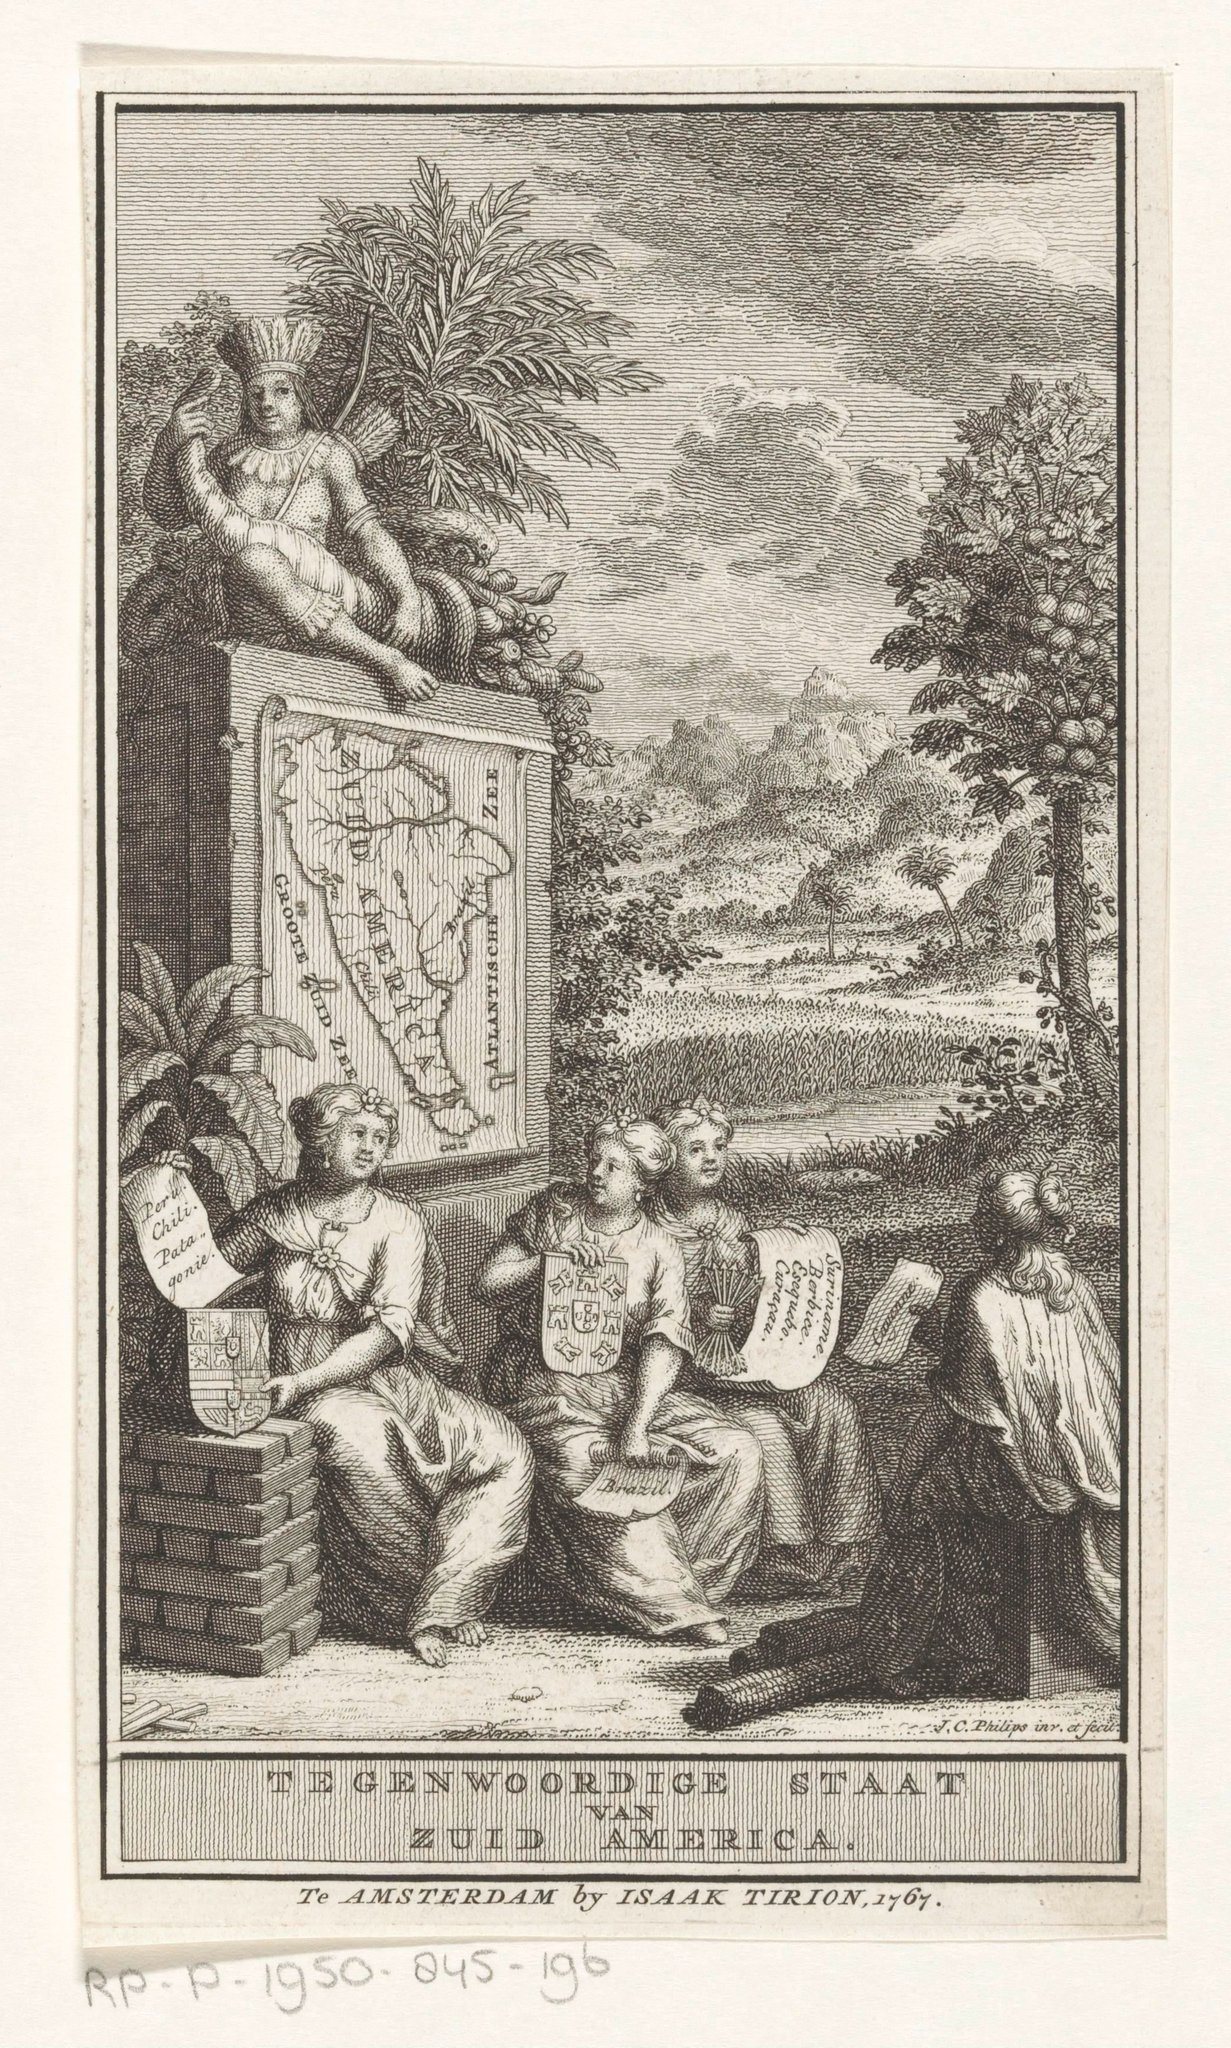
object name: print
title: Allegorie op Zuid-Amerika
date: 1767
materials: paper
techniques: engraving, etching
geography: amsterdam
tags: america represented allegorically; 'america' (ripa), landscapes in the non-temperate zone, exotic landscapes - kk - ideal landscapes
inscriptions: collector's mark: Lugt 2228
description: Titelpagina voor: Salmon, Thomas. Hedendaagsche historie of tegenwoordige staat van America (...) Eerste deel. Amsterdam: Tirion, Isaak, 1767. Prent afkomstig uit een plakalbum met titelprenten, ornamenten etc. op blauw papier in 1983 uit elkaar gehaald. Volgens een notitie op verso zat de prent op p. 196 van dit album.